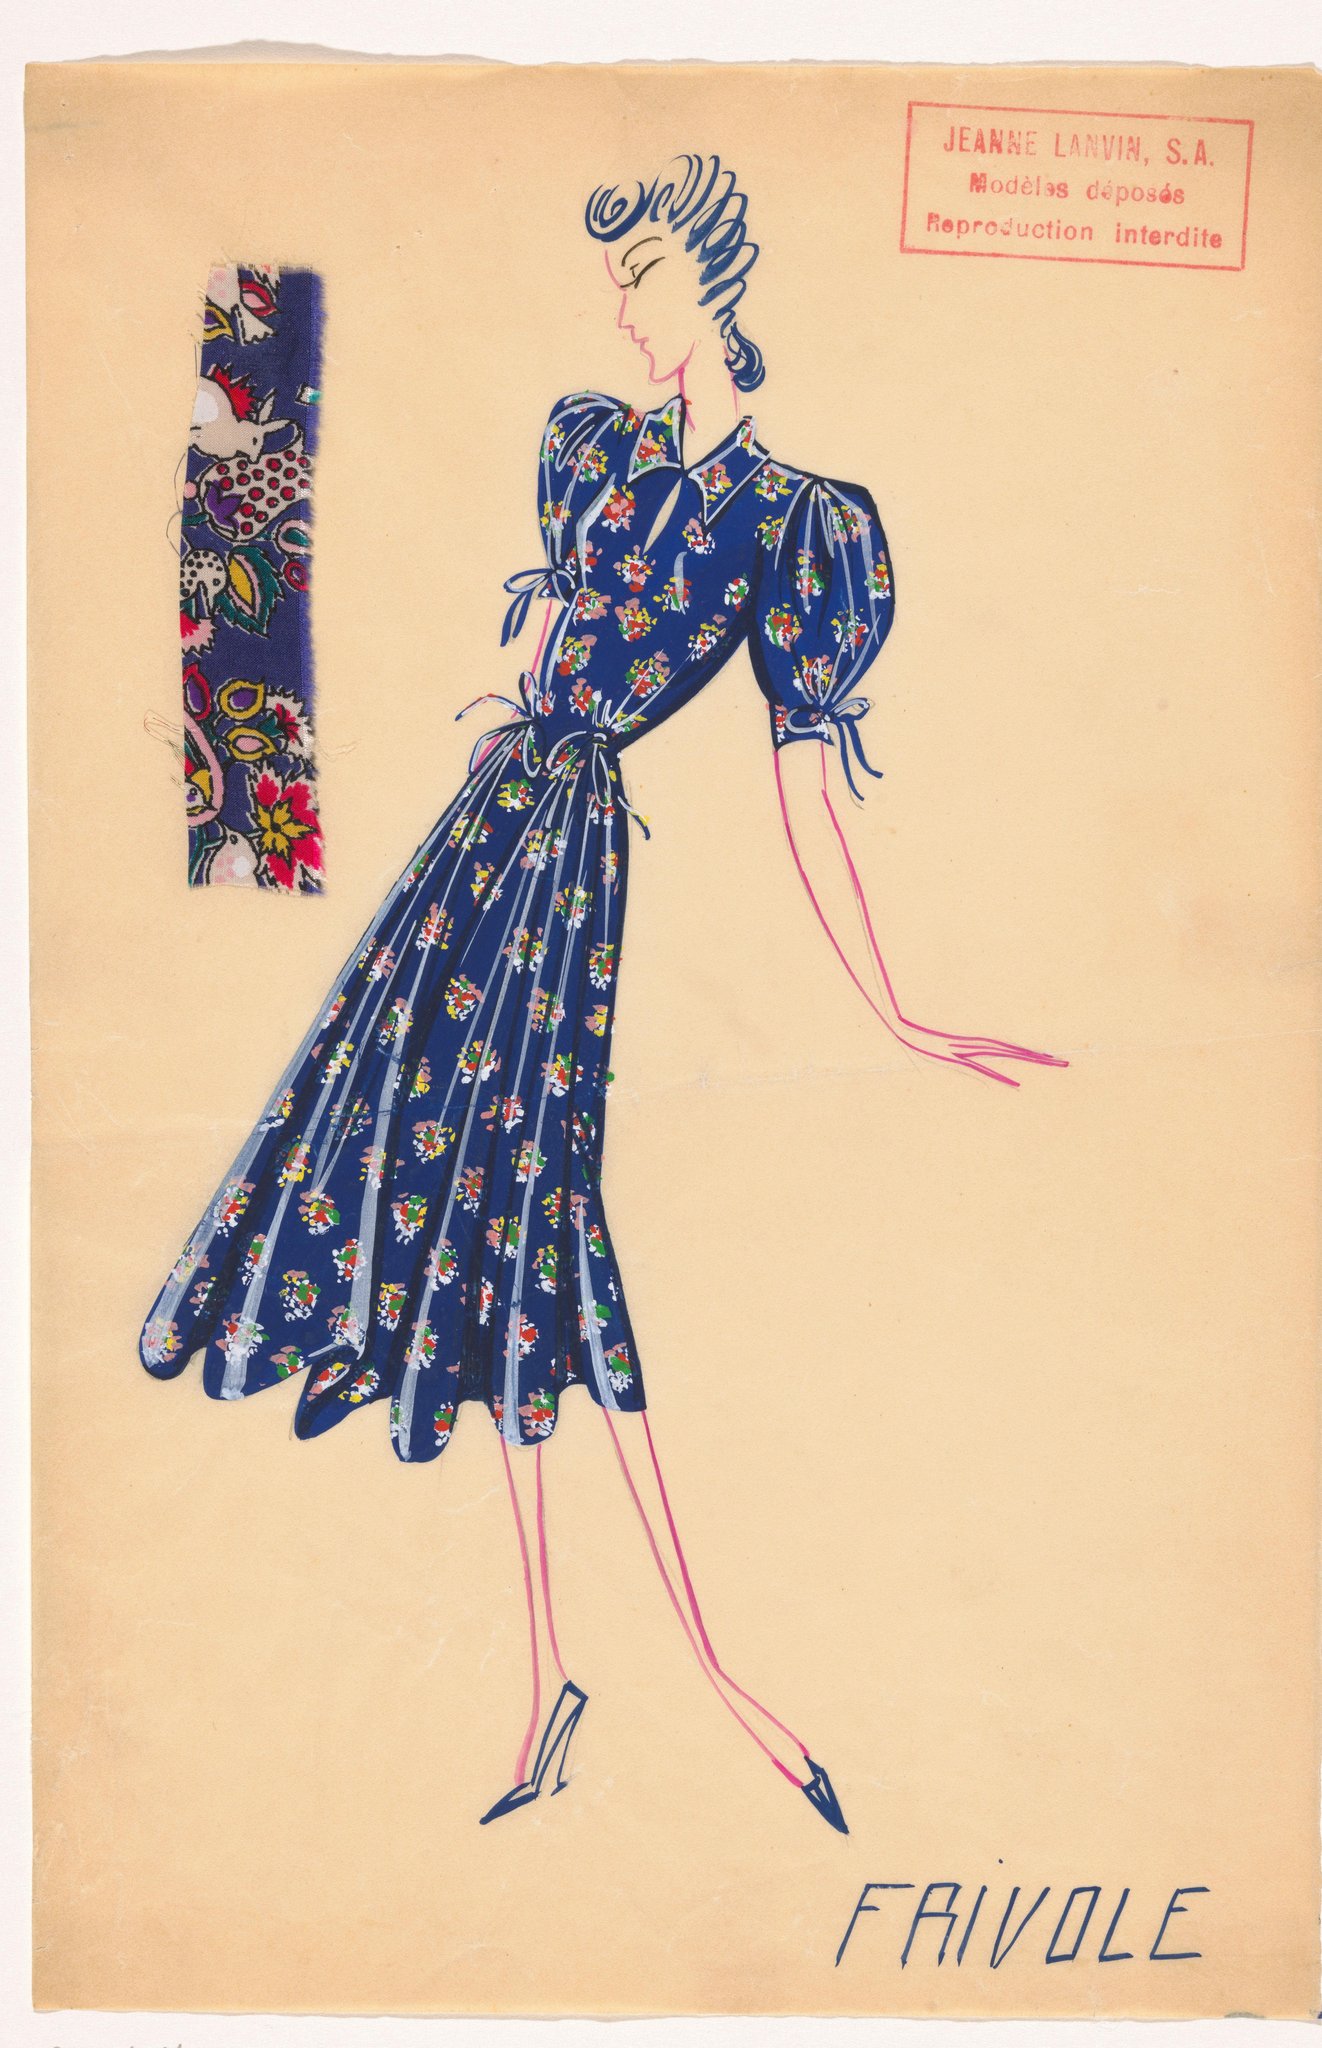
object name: fashion plate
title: Frivole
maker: jeanne lanvin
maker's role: couturier, modeontwerper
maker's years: 1867-1946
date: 1937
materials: gouache, paper, pencil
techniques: brush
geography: paris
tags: bow (ornamental part of clothing) (+ women's clothes), fashion plates, dress, gown (+ women's clothes)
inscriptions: stamp: ‘Jeanne Lanvin, S.A./Modèles déposés/Réproduction interdite.’, title: ‘Frivole’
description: Japon van blauwe zijde bedrukt met een veelkleurig strooimotief met bloemen en kleine dieren. Nauwsluitend lijf met split en puntkraagje. Poffende mouwen met strik op de manchet. Klokkende rok met strikken in de taille. Linksboven een staaltje stof. Rechtsonder de naam Frivole. Rechtsboven stempel modehuis Jeanne Lanvin.